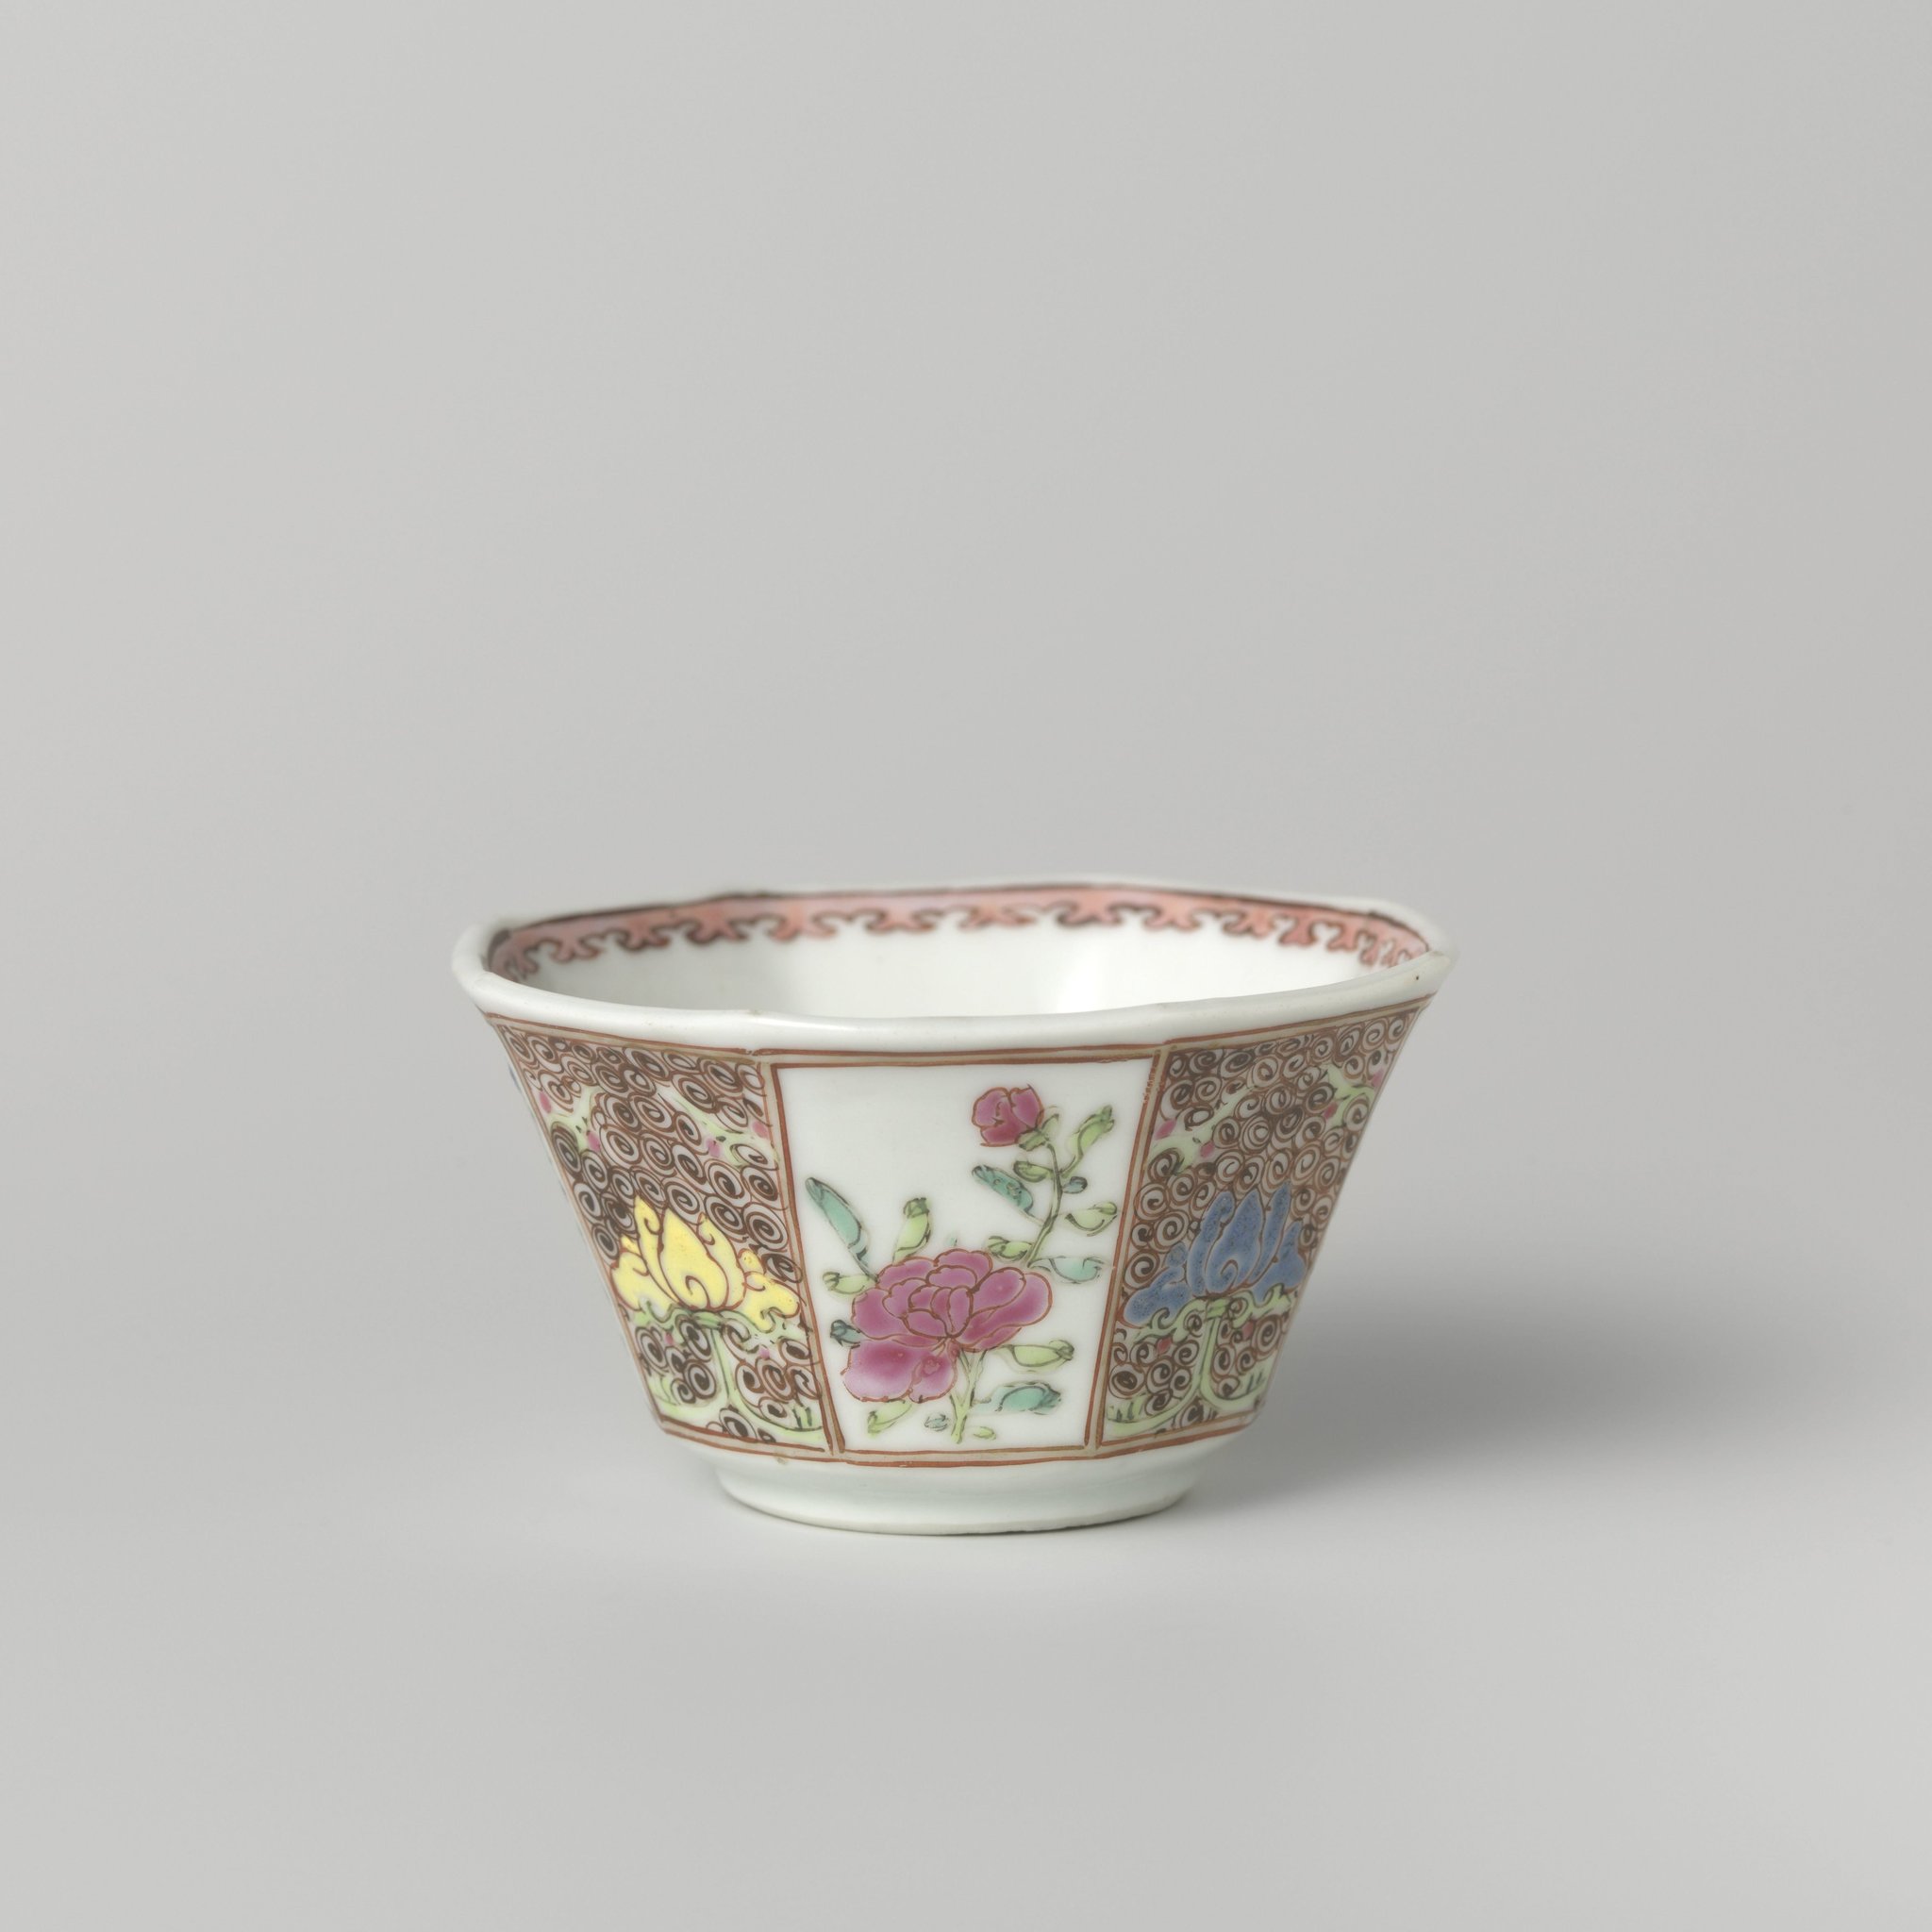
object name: kop en schotel, kop en schotel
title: Octagonal cup with flower sprays and lotus scrolls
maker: Anonymous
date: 1725-1749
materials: glaze, paint, porcelain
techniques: firing, forming, turning, vitrification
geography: china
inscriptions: label: ‘Pag: 48’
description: Achthoekige kop van porselein met uitlopende wand, beschilderd op het glazuur in blauw, rood, roze, groen, geel en zwart. Bloeiende planten (pioen, aster) en een vlinder afgebeeld; op de wand acht vakken met afwisselend een bloemtak (pioen, prunus, prachtanjer) en lotusranken tegen een achtergrond van servetwerk. Famille rose.